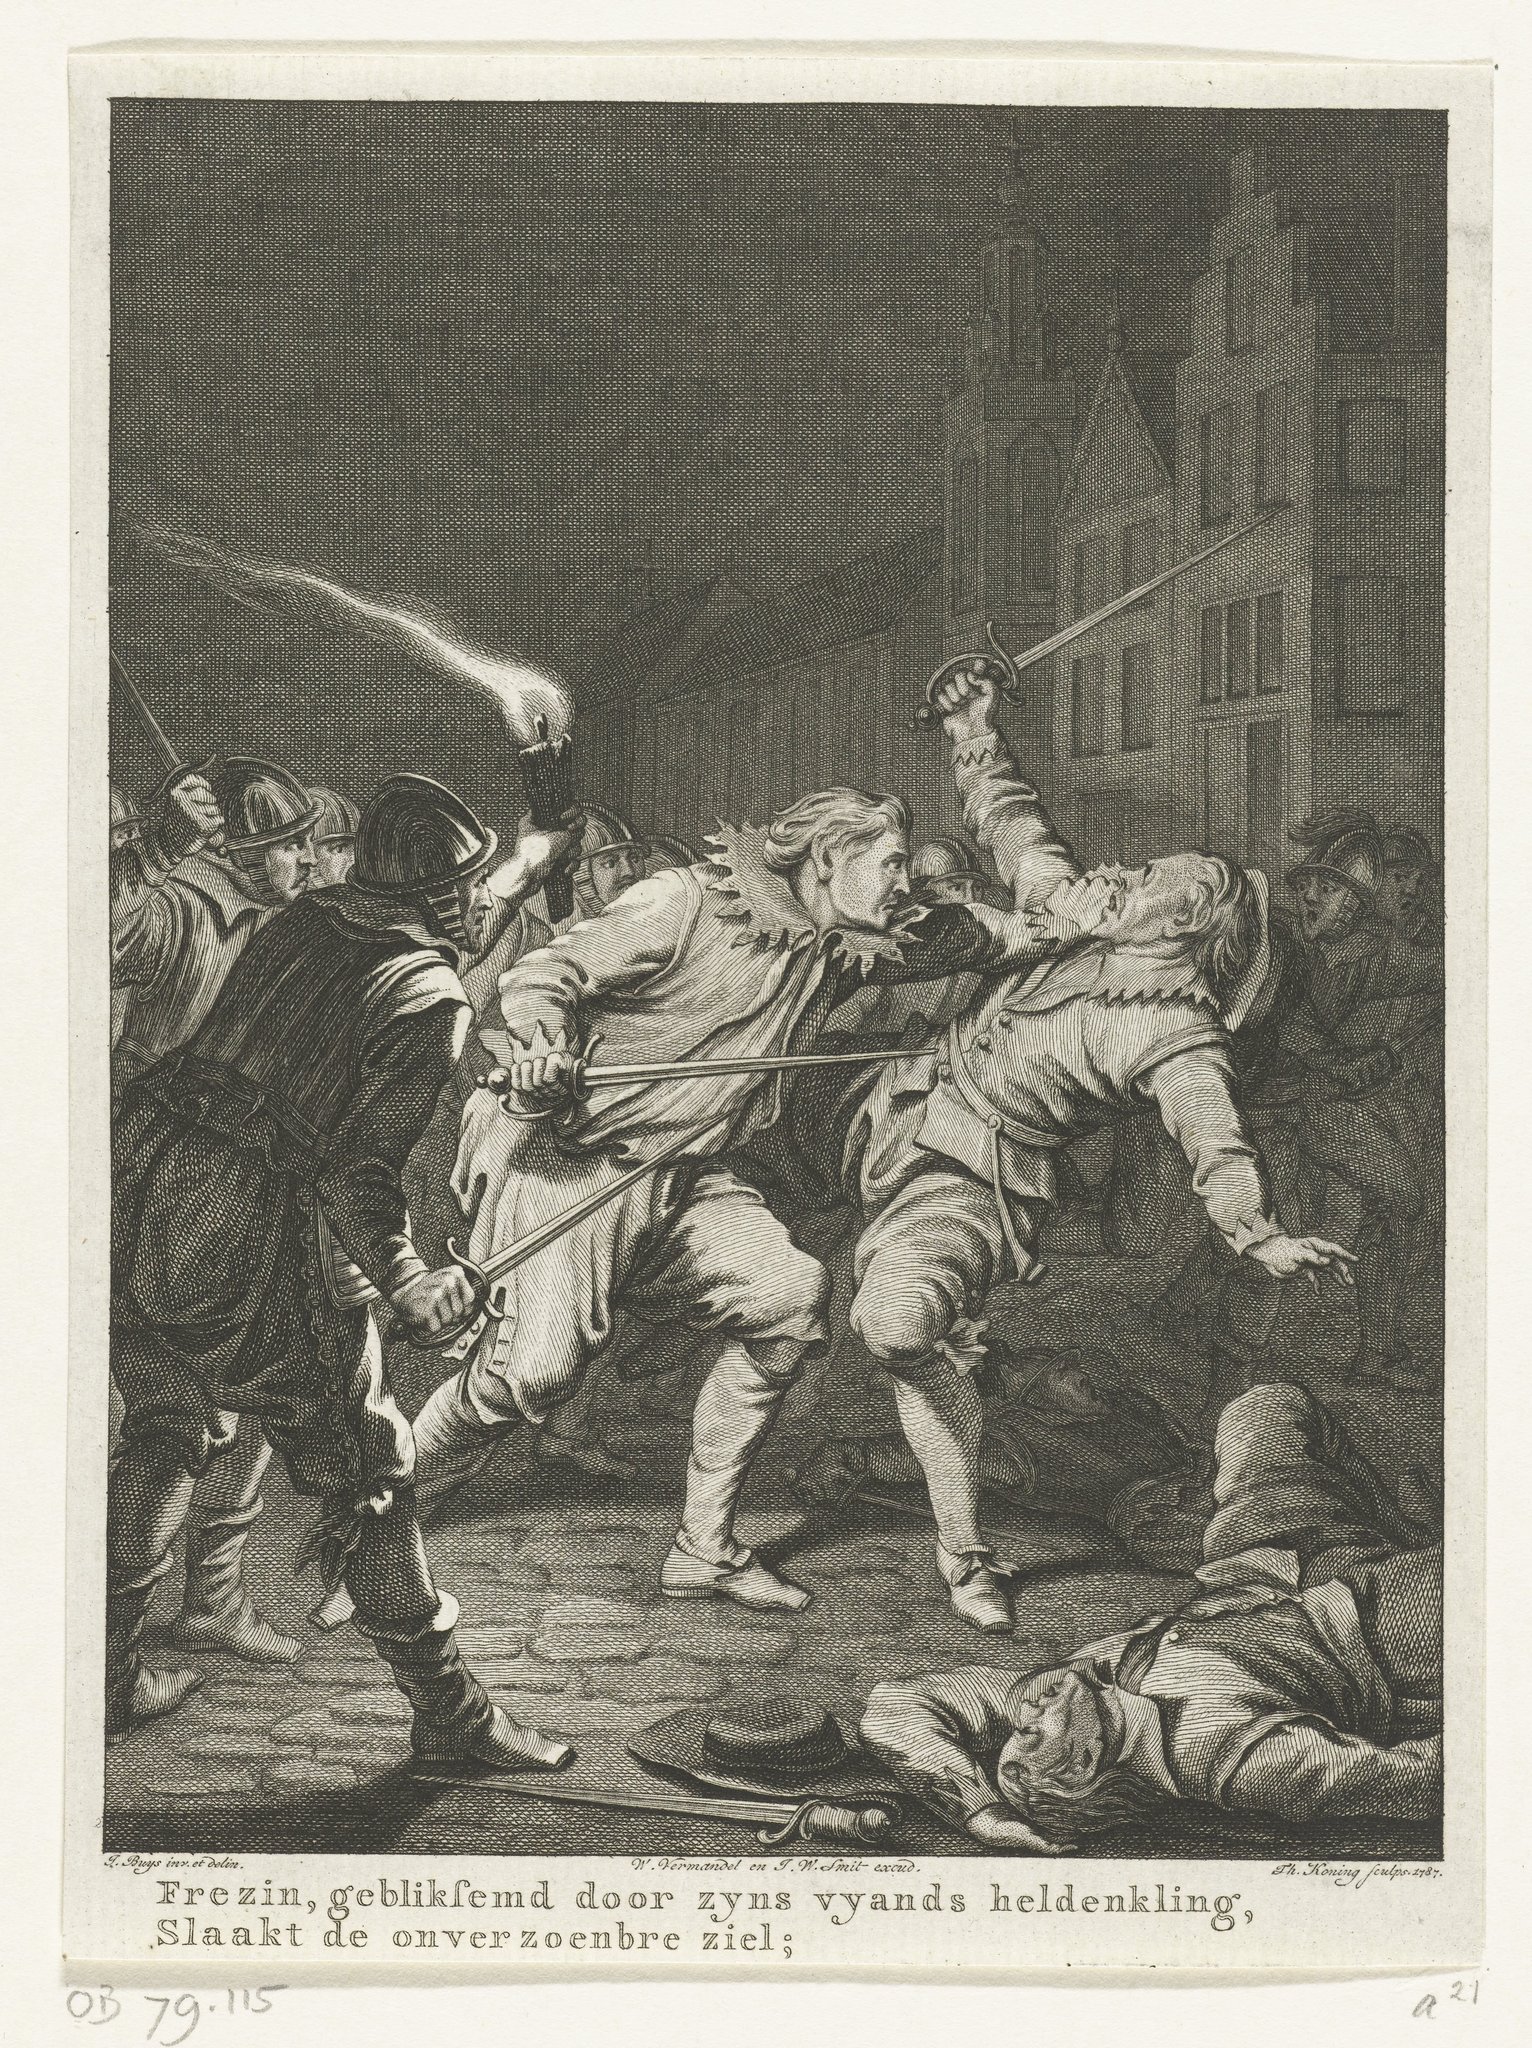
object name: history print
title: Frezin, gebliksemd door zyns vyands heldenkling, / Slaakt de onverzoenbre ziel;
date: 1787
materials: paper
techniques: etching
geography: northern netherlands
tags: violent death, being killed; being mishandled and maltreated; seeking death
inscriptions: date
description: Illustratie voor: J. Nomsz, Willem de eerste, of de grondlegging der Nederlandsche vryheid. : In vier en twintig zangen, Erven van David Klippink, Amsterdam 1779. Staat met de letter.